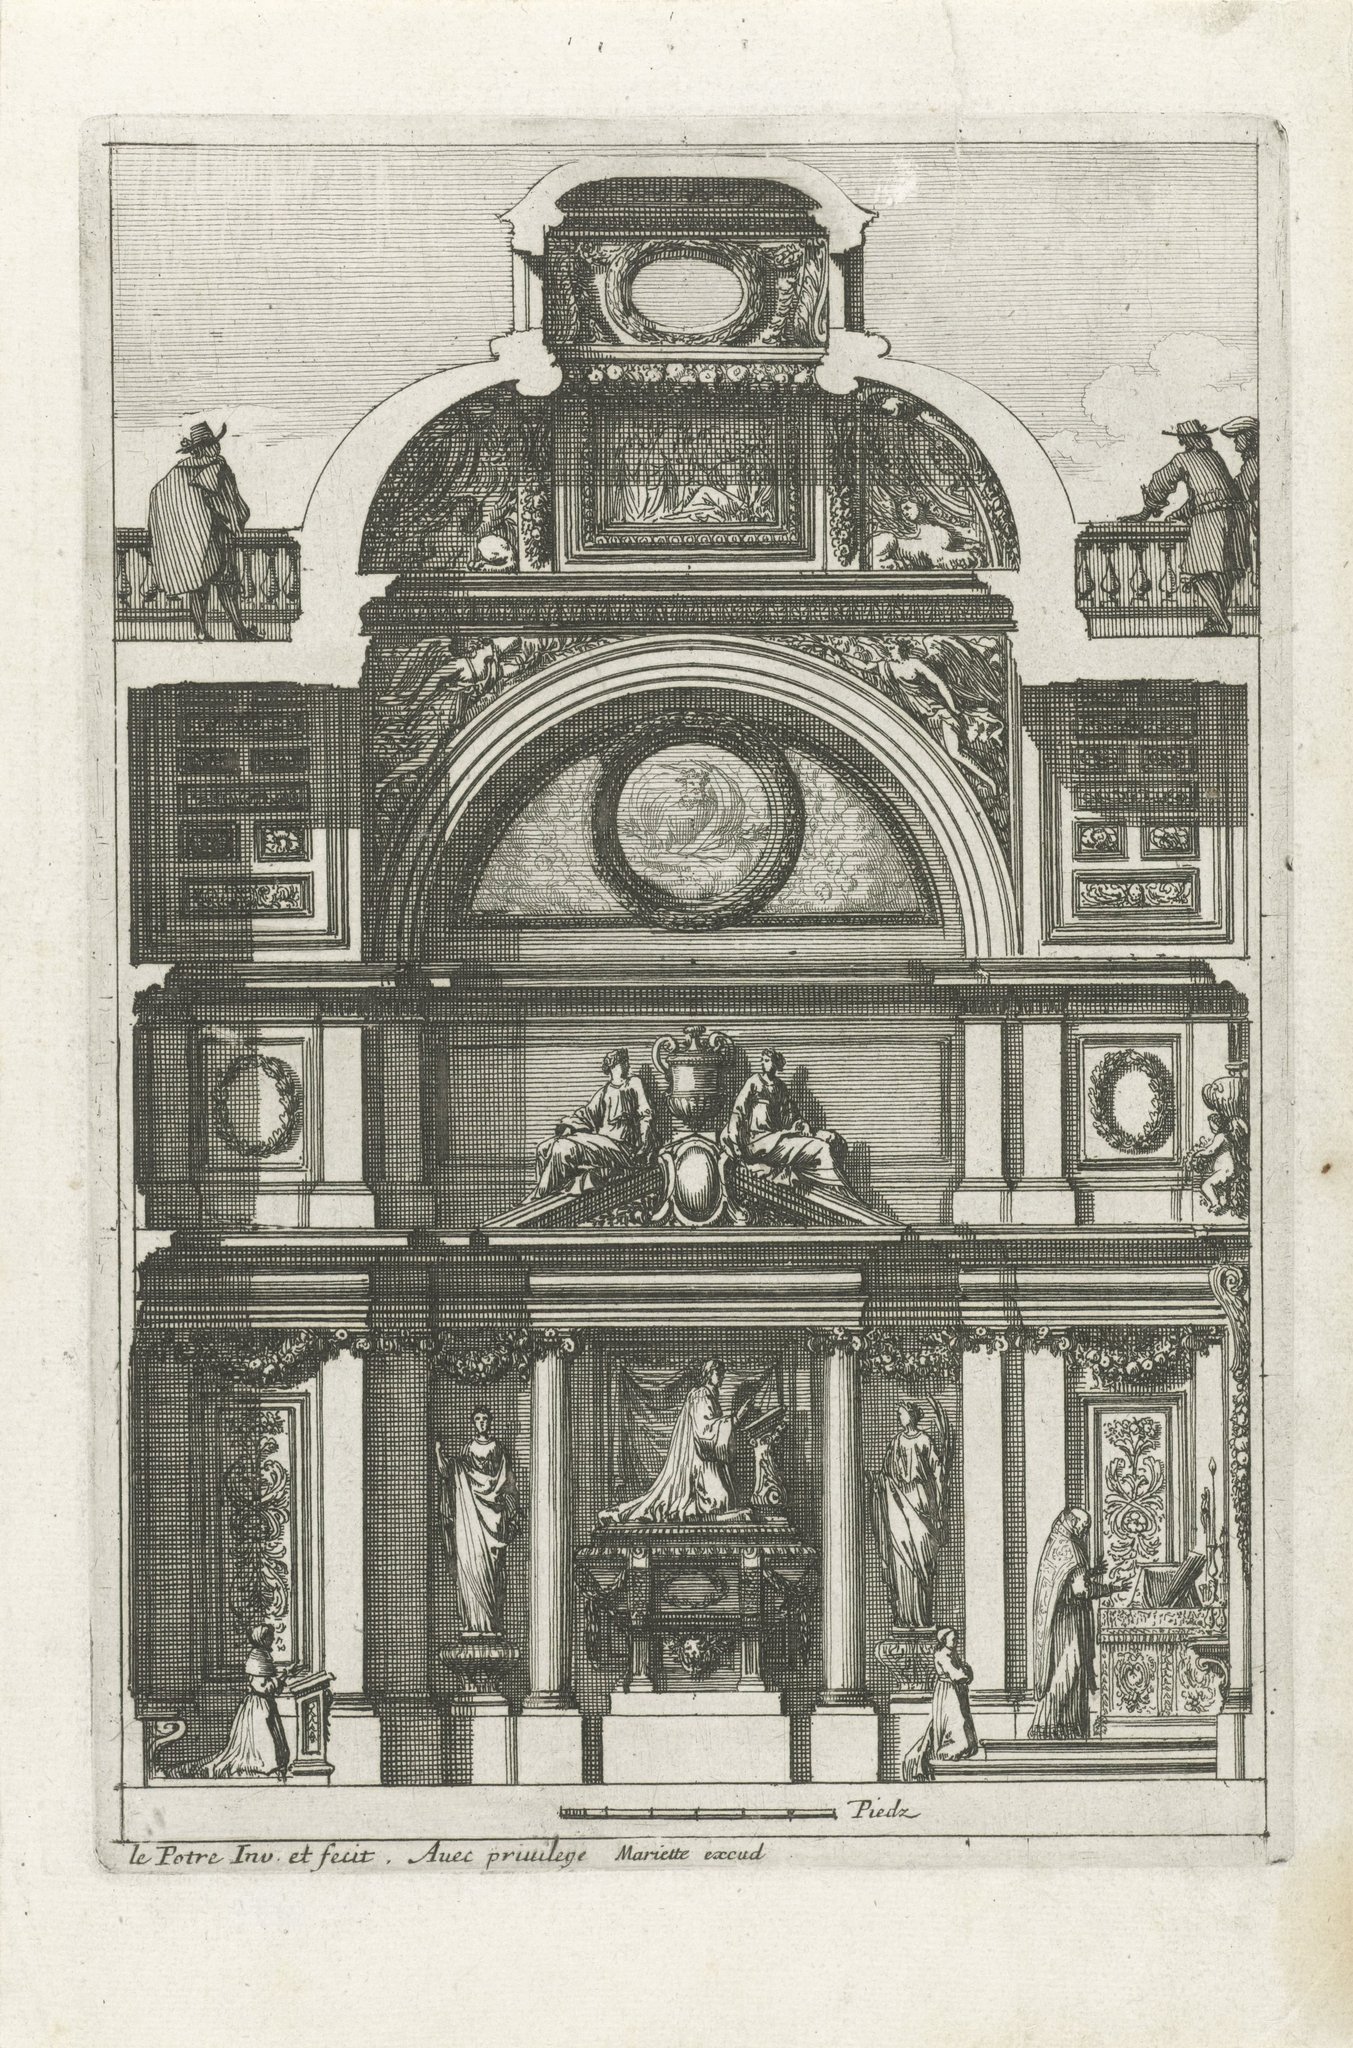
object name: print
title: Tombeaux ou Mozoles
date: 1661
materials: paper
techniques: etching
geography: france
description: Onderaan staat een grafmonument tegen de muur, de overledene knielt op de kist.